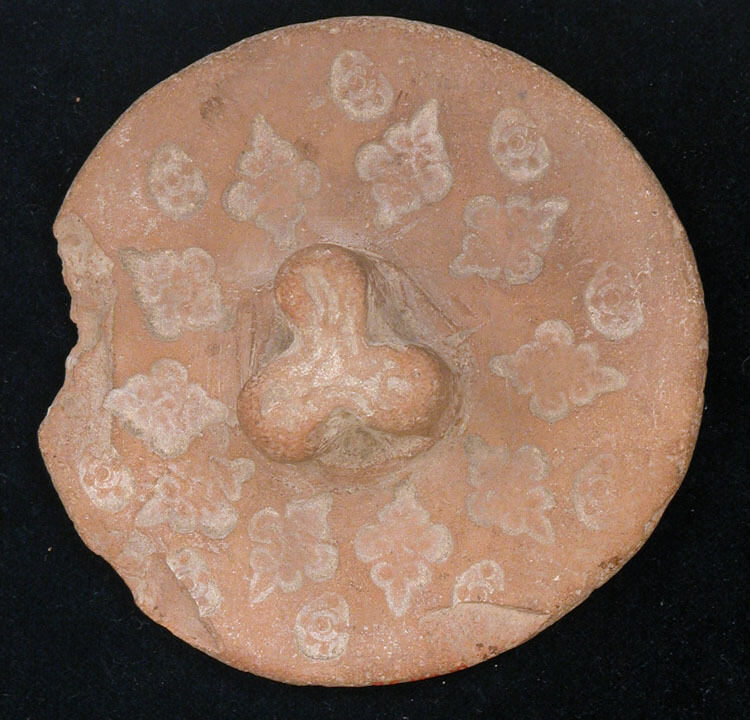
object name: bath scraper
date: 1101-1300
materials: earthenware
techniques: molding, relief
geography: iran